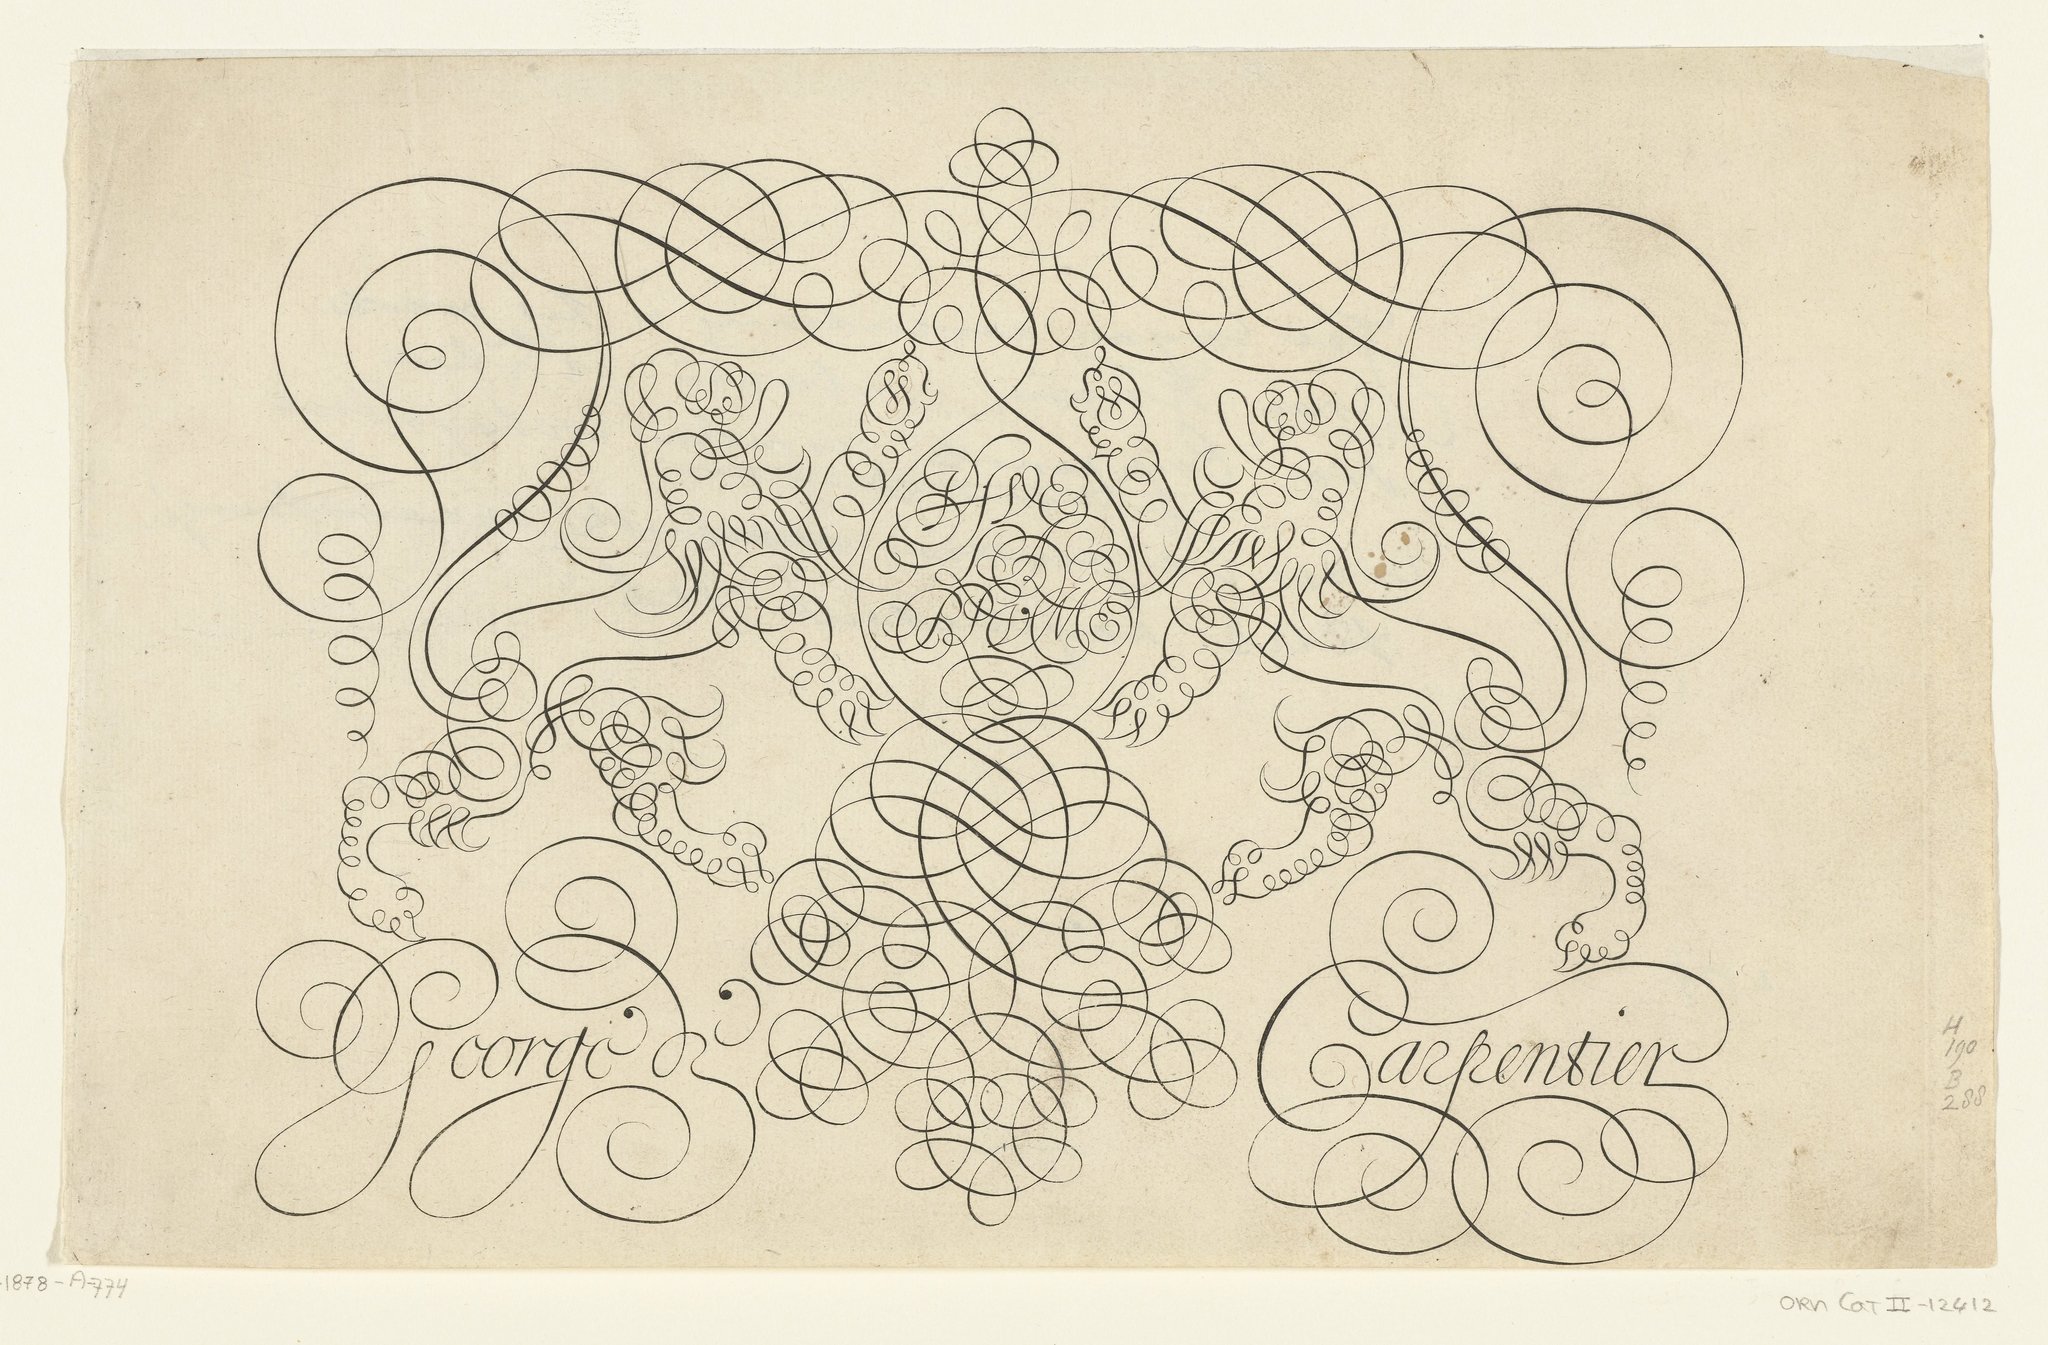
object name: ornament print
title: Exemplaer-Boeck. Inhoudende d'alder-gebruyckelyckste Geschriften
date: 1608-1618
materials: paper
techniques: engraving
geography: amsterdam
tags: calligraphy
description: Een ovaal schild met het opschrift Vive la plume, vastgehouden door twee leeuwen. Blad uit serie bestaande uit een titelblad en 15 bladen met kalligrafie voorbeelden.